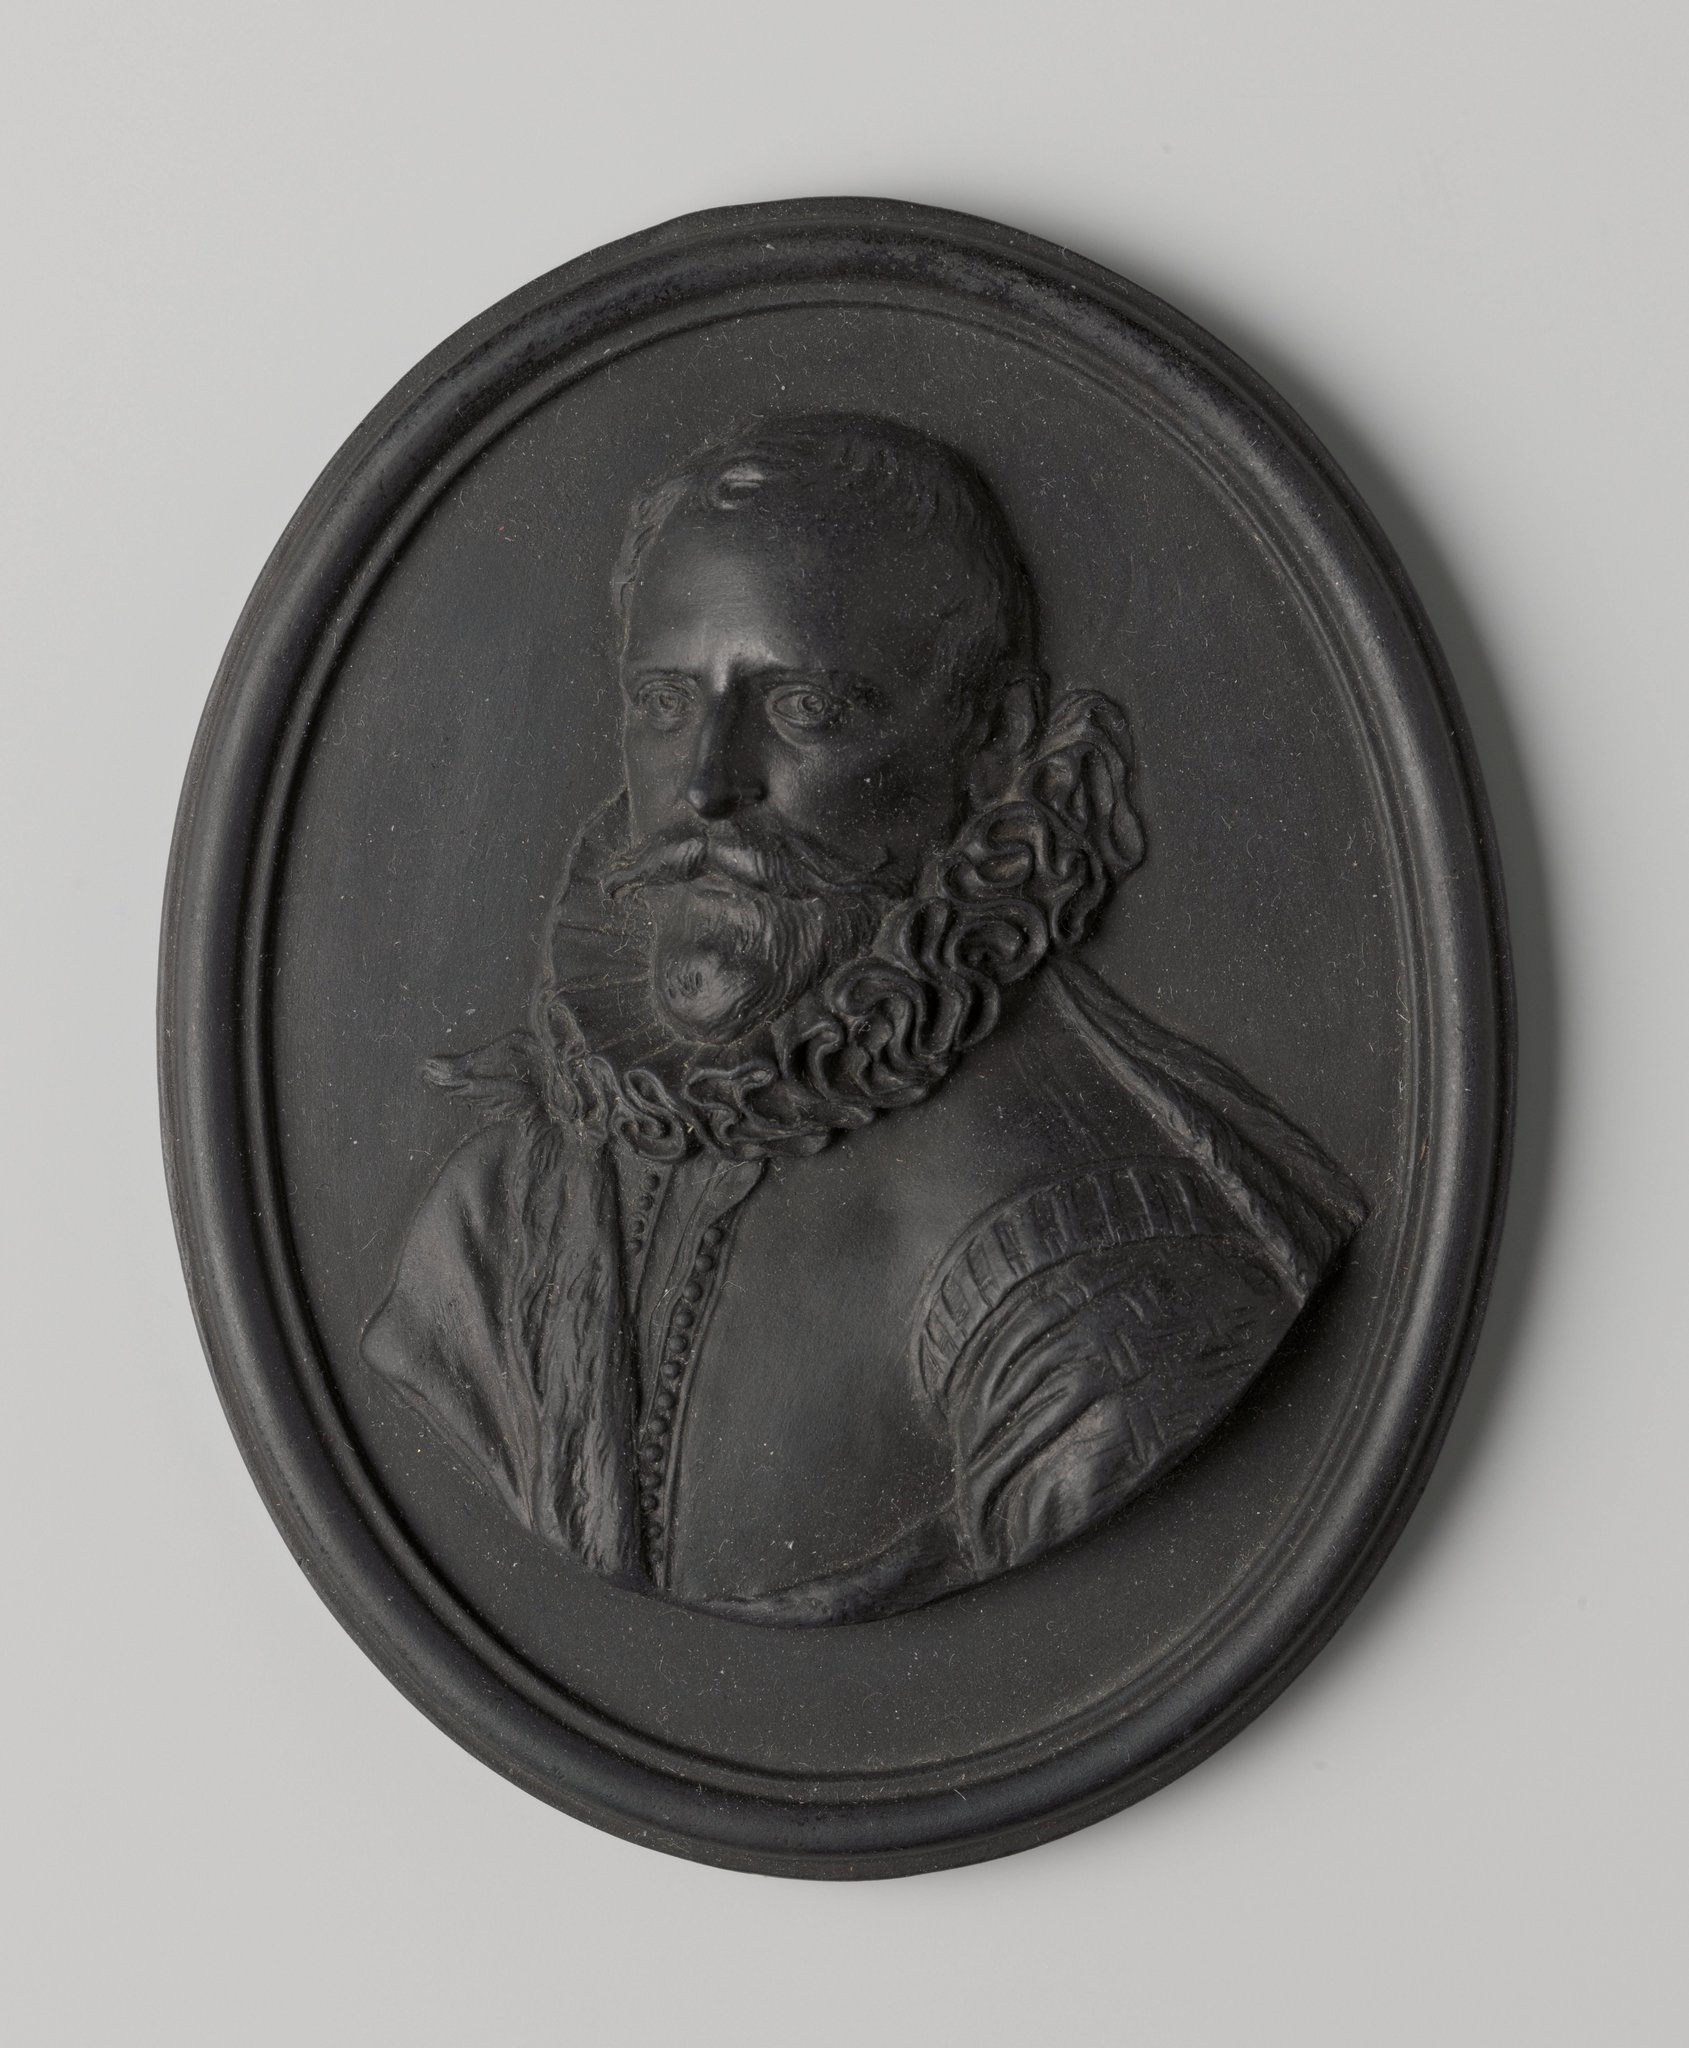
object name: plaque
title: Plaquette met portret van Rombout Hogerbeets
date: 1780-1800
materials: stoneware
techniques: firing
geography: england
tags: hoorn (north holland)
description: Ovale plaquette van zwart steengoed (black basalt) met in reliëf het portret van Rombout Hogerbeets. Op de achterzijde gemerkt: Wedgwood en Hogerbeets.